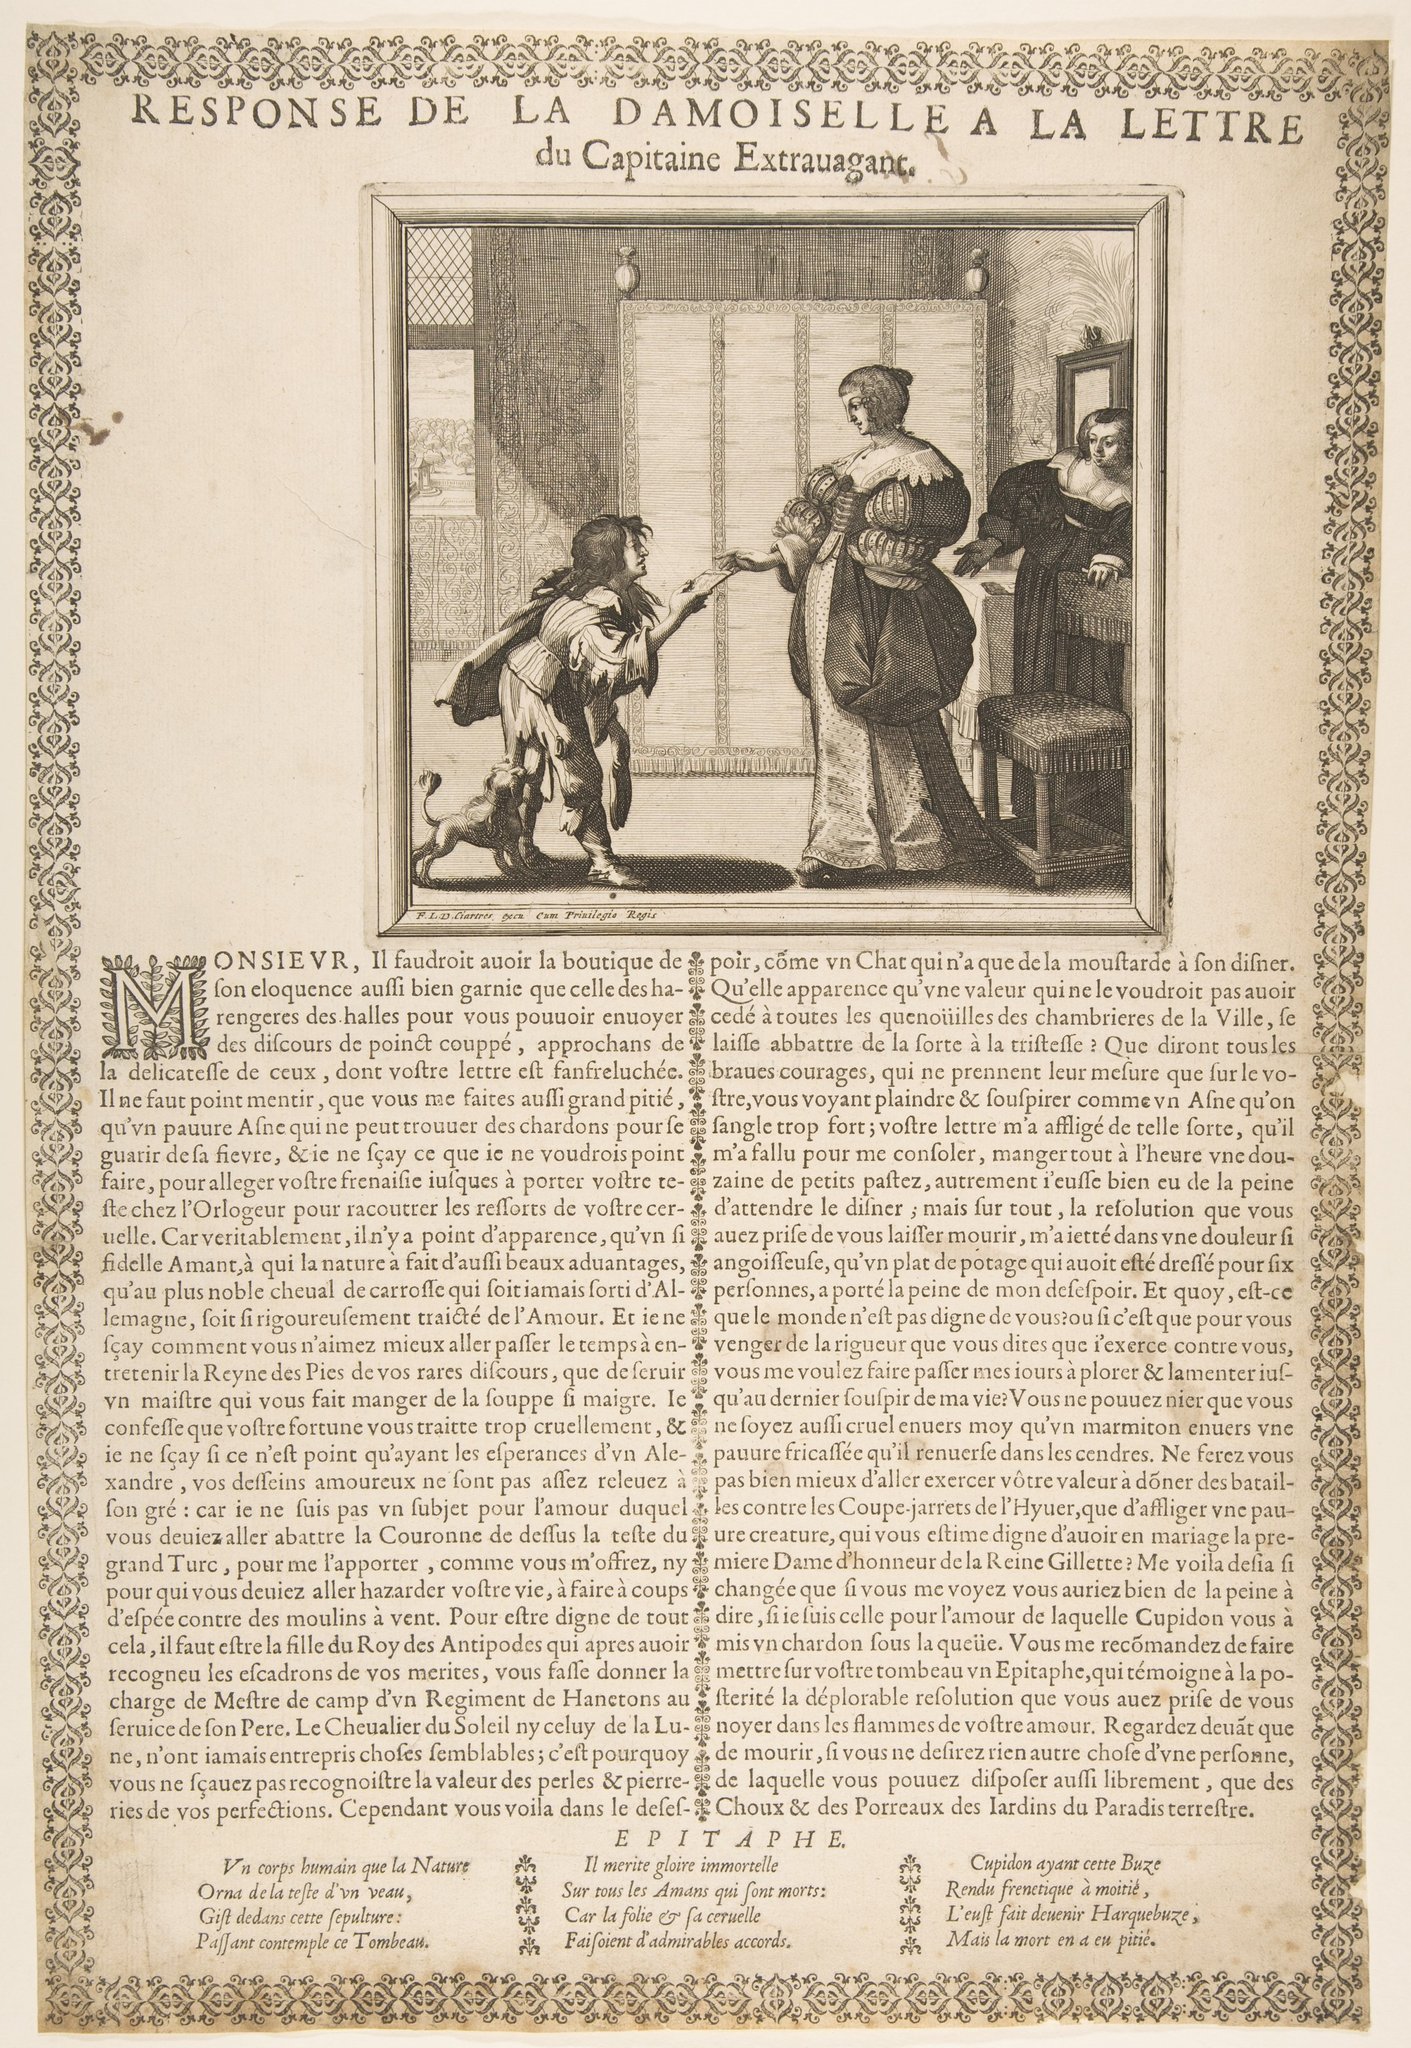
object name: print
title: Young Lady's Reply to the Captain's Letter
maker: abraham bosse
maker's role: artist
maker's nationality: french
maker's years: 1602-1676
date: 1636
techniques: etching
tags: men,women